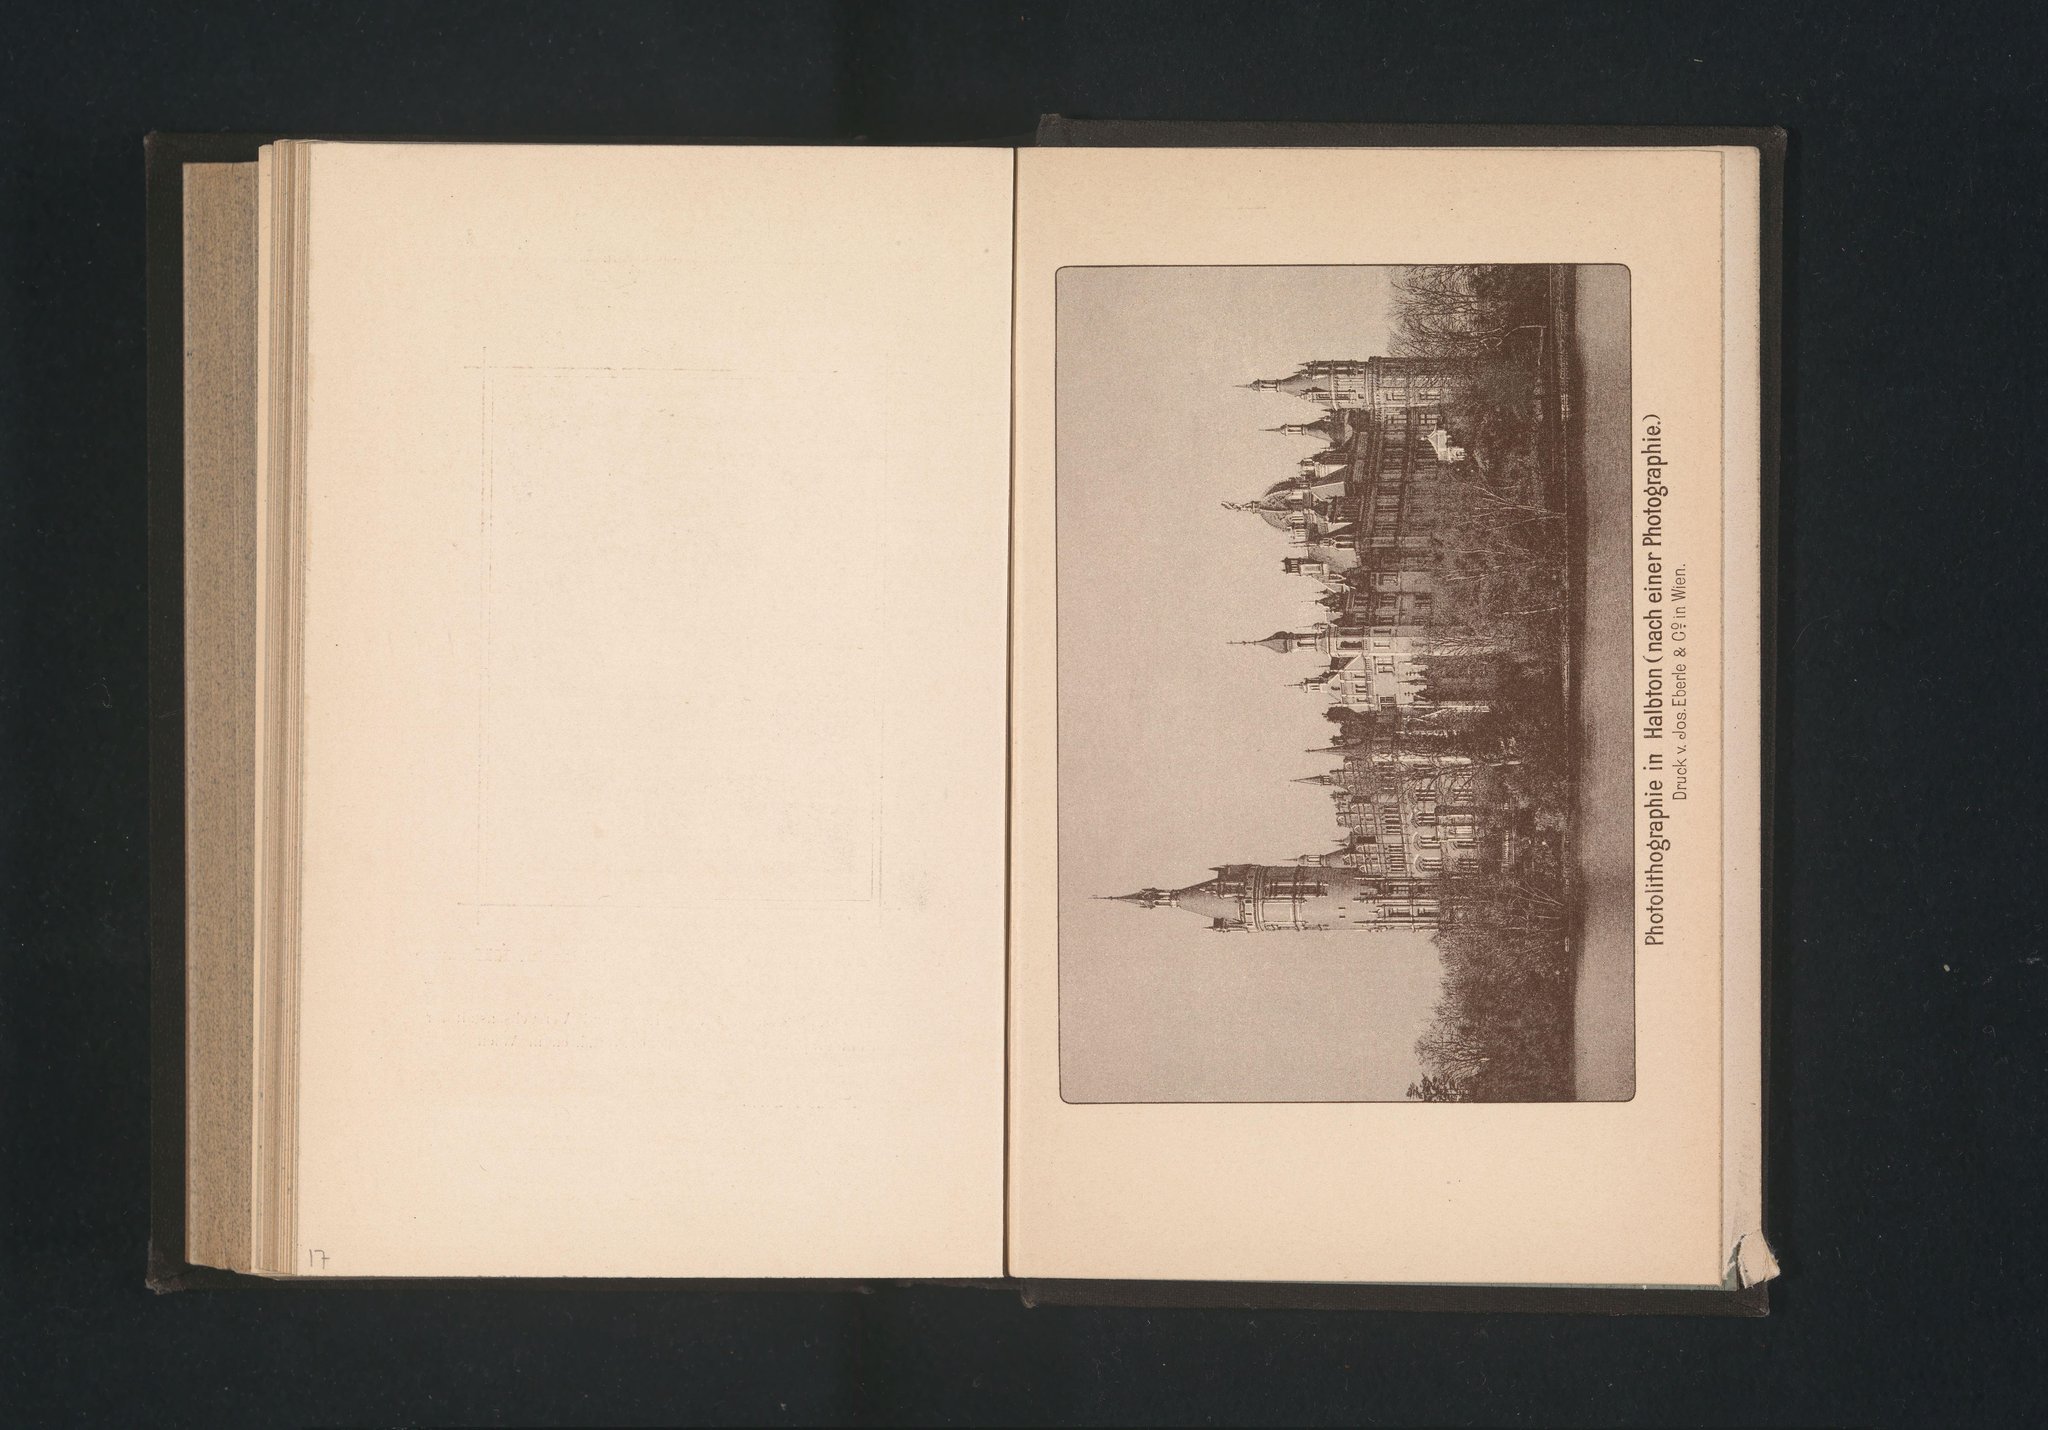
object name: page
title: Gezicht op een kasteel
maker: Anonymous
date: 1886-1891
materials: paper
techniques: autotype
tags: castle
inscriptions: inscription: ‘Photolithographie in Balbton (nach einer Photographie)’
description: Prent op vierenveertigste ongenummerde pagina na pagina 627.